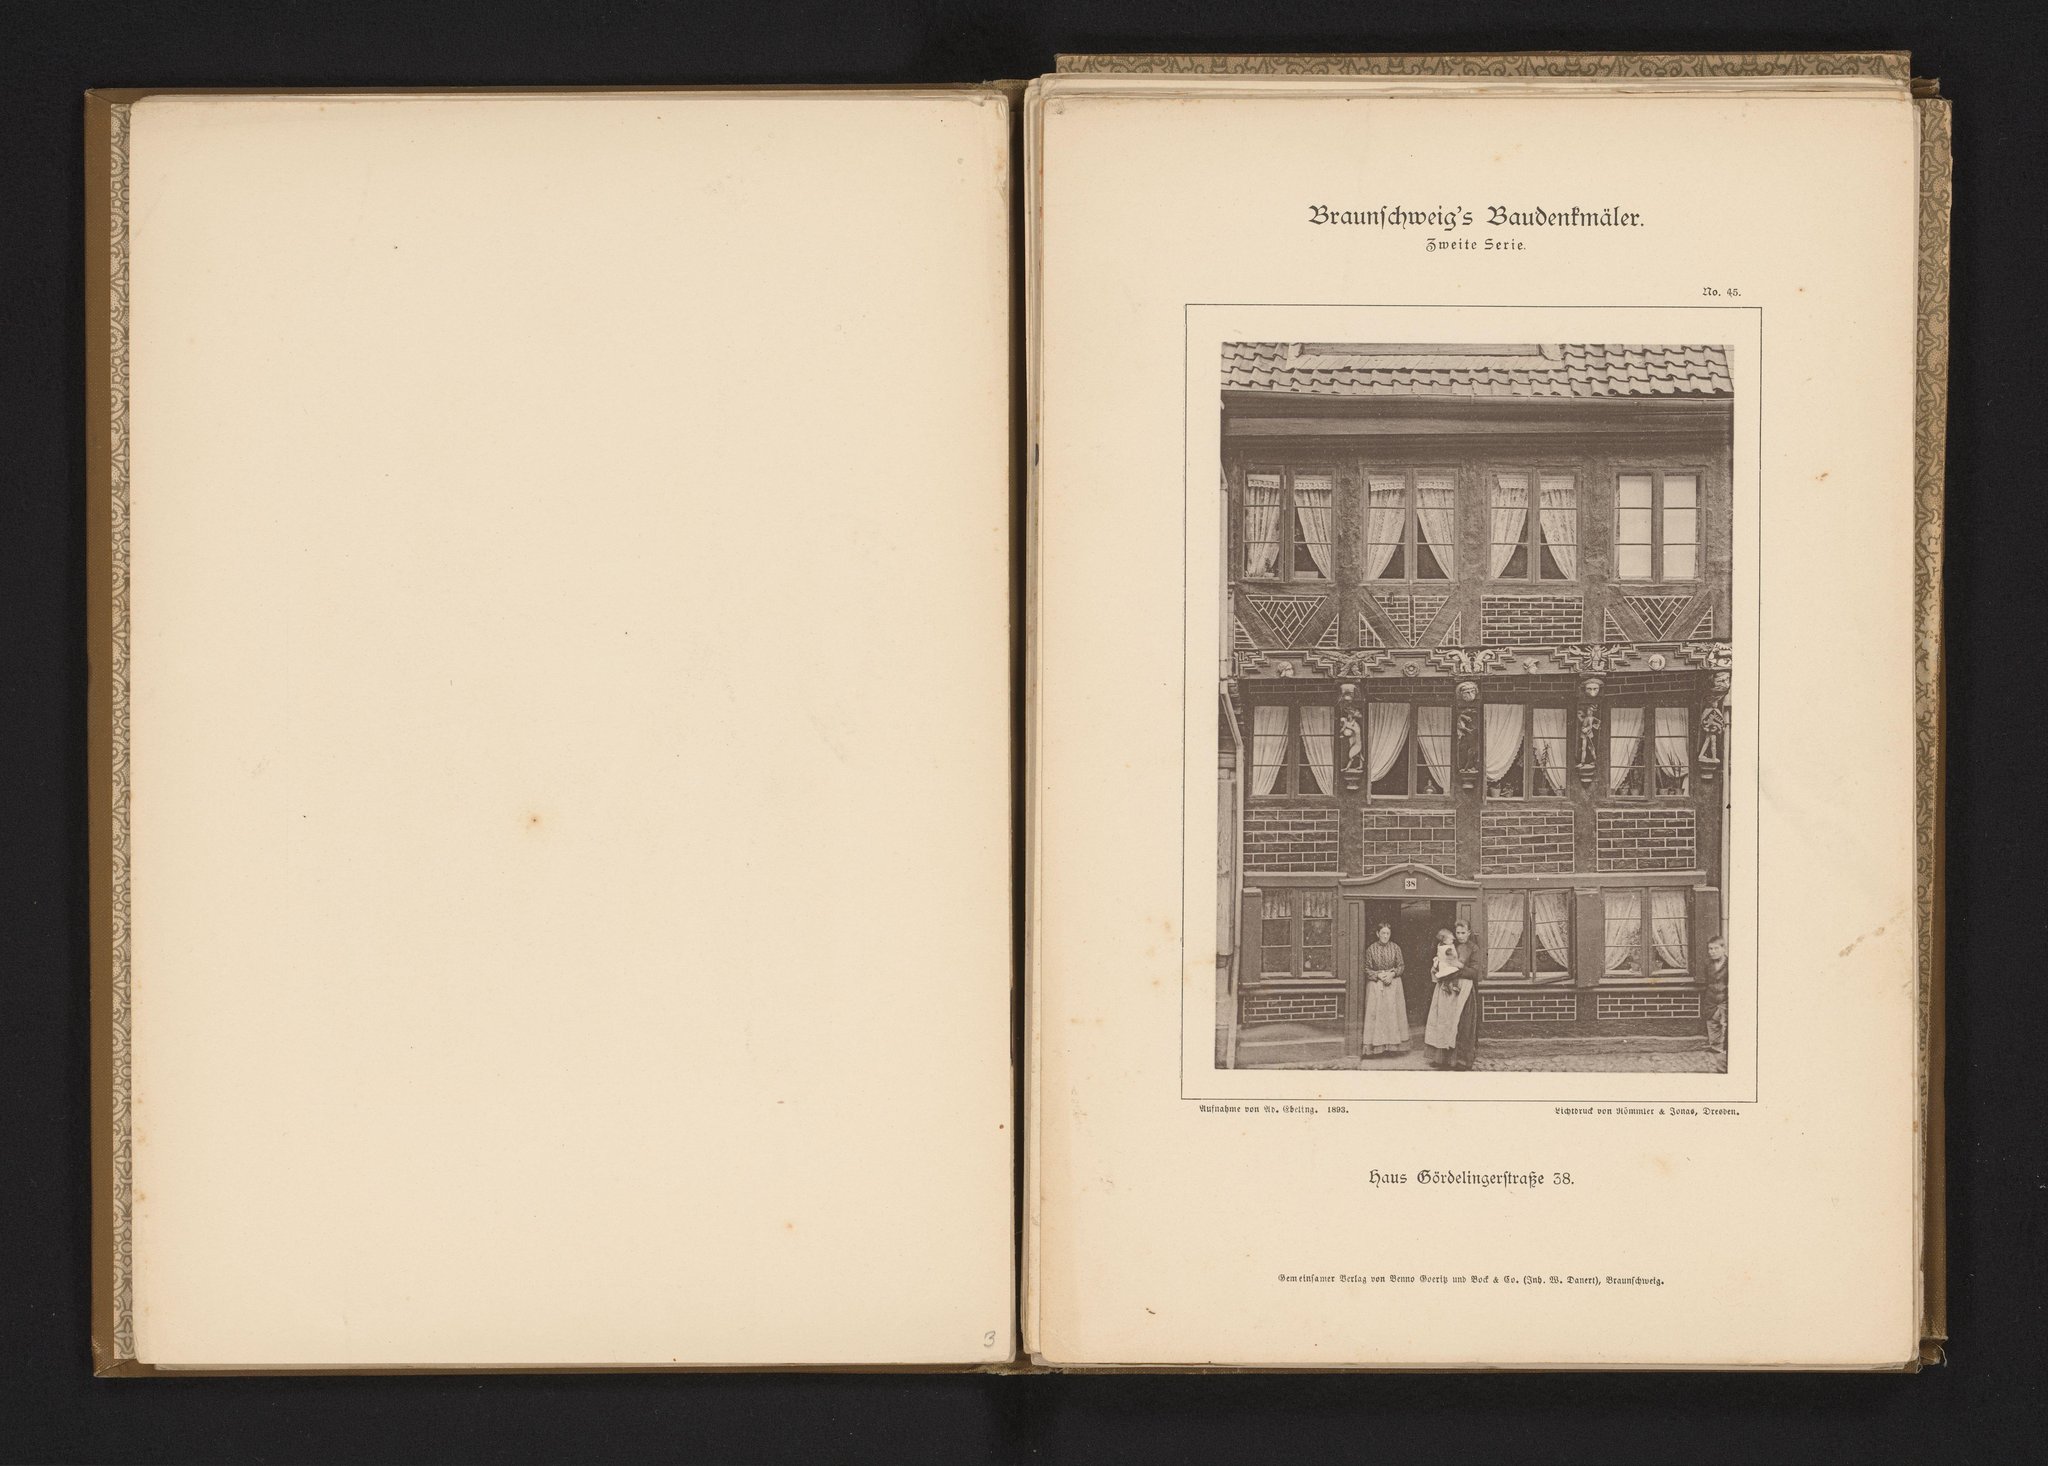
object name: photomechanical print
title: Gevel van het woonhuis aan Gördelingerstraße 38 te Braunschweig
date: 1893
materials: paper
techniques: photograph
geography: braunschweig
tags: housing, façade (of house or building)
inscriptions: number: ‘No. 45.’